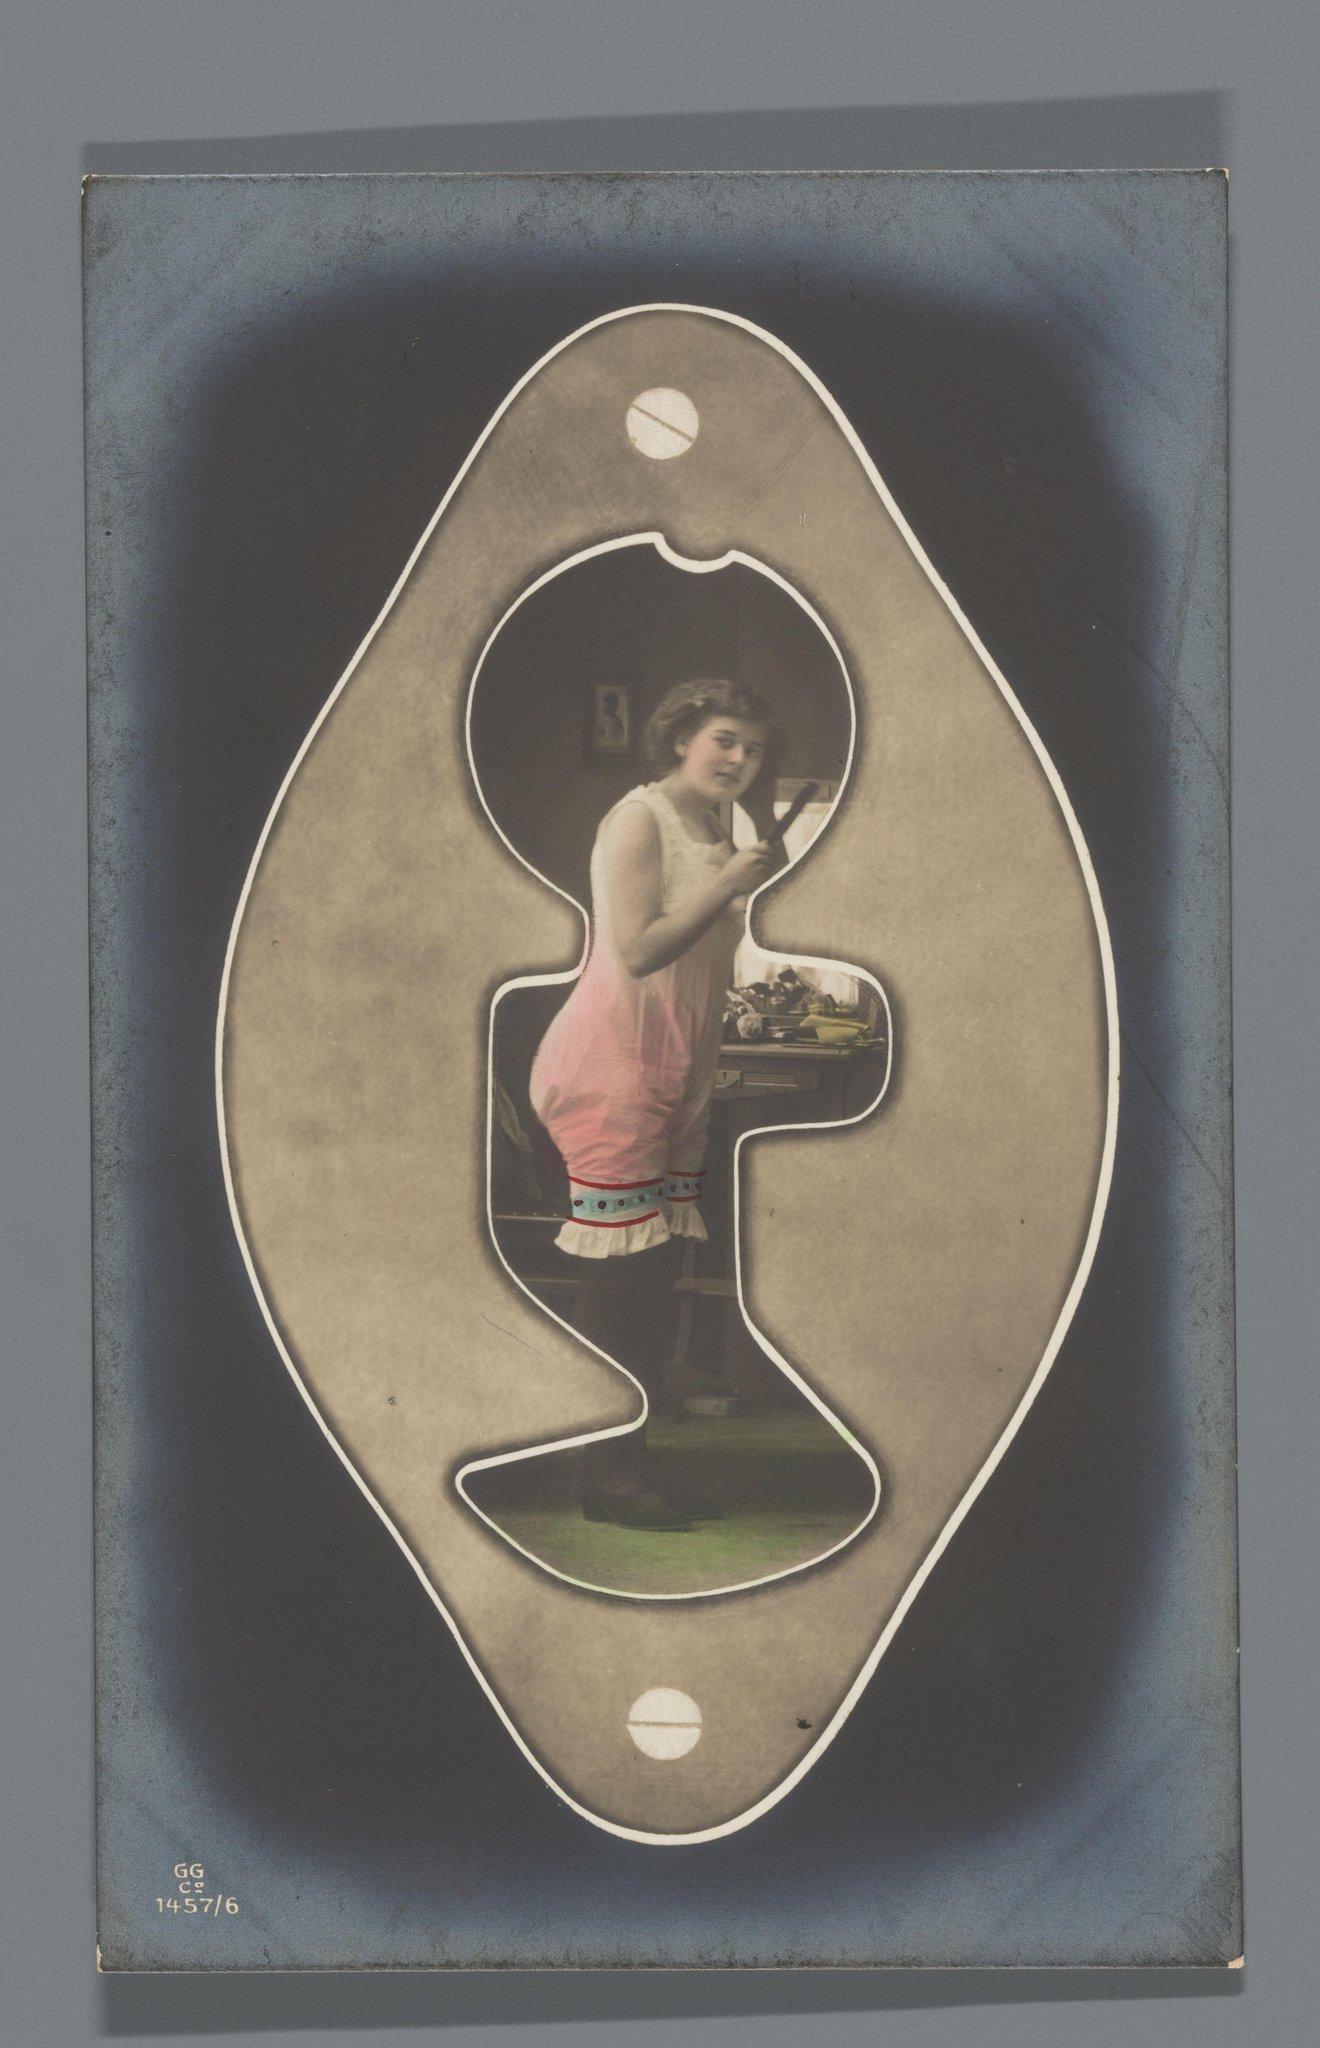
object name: ansichtkaart, prentbriefkaart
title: Vrouw die zich ontkleedt en opmaakt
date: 1920-1930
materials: paper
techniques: gelatin silver print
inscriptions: inscription: ‘GG / Co / 1457/6’, inscription: ‘P.R.A.’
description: Een van zes postkaarten/prentbriefkaarten met een voorstelling van een vrouw die zich ontkleedt en opmaakt, gezien door een sleutelgat.